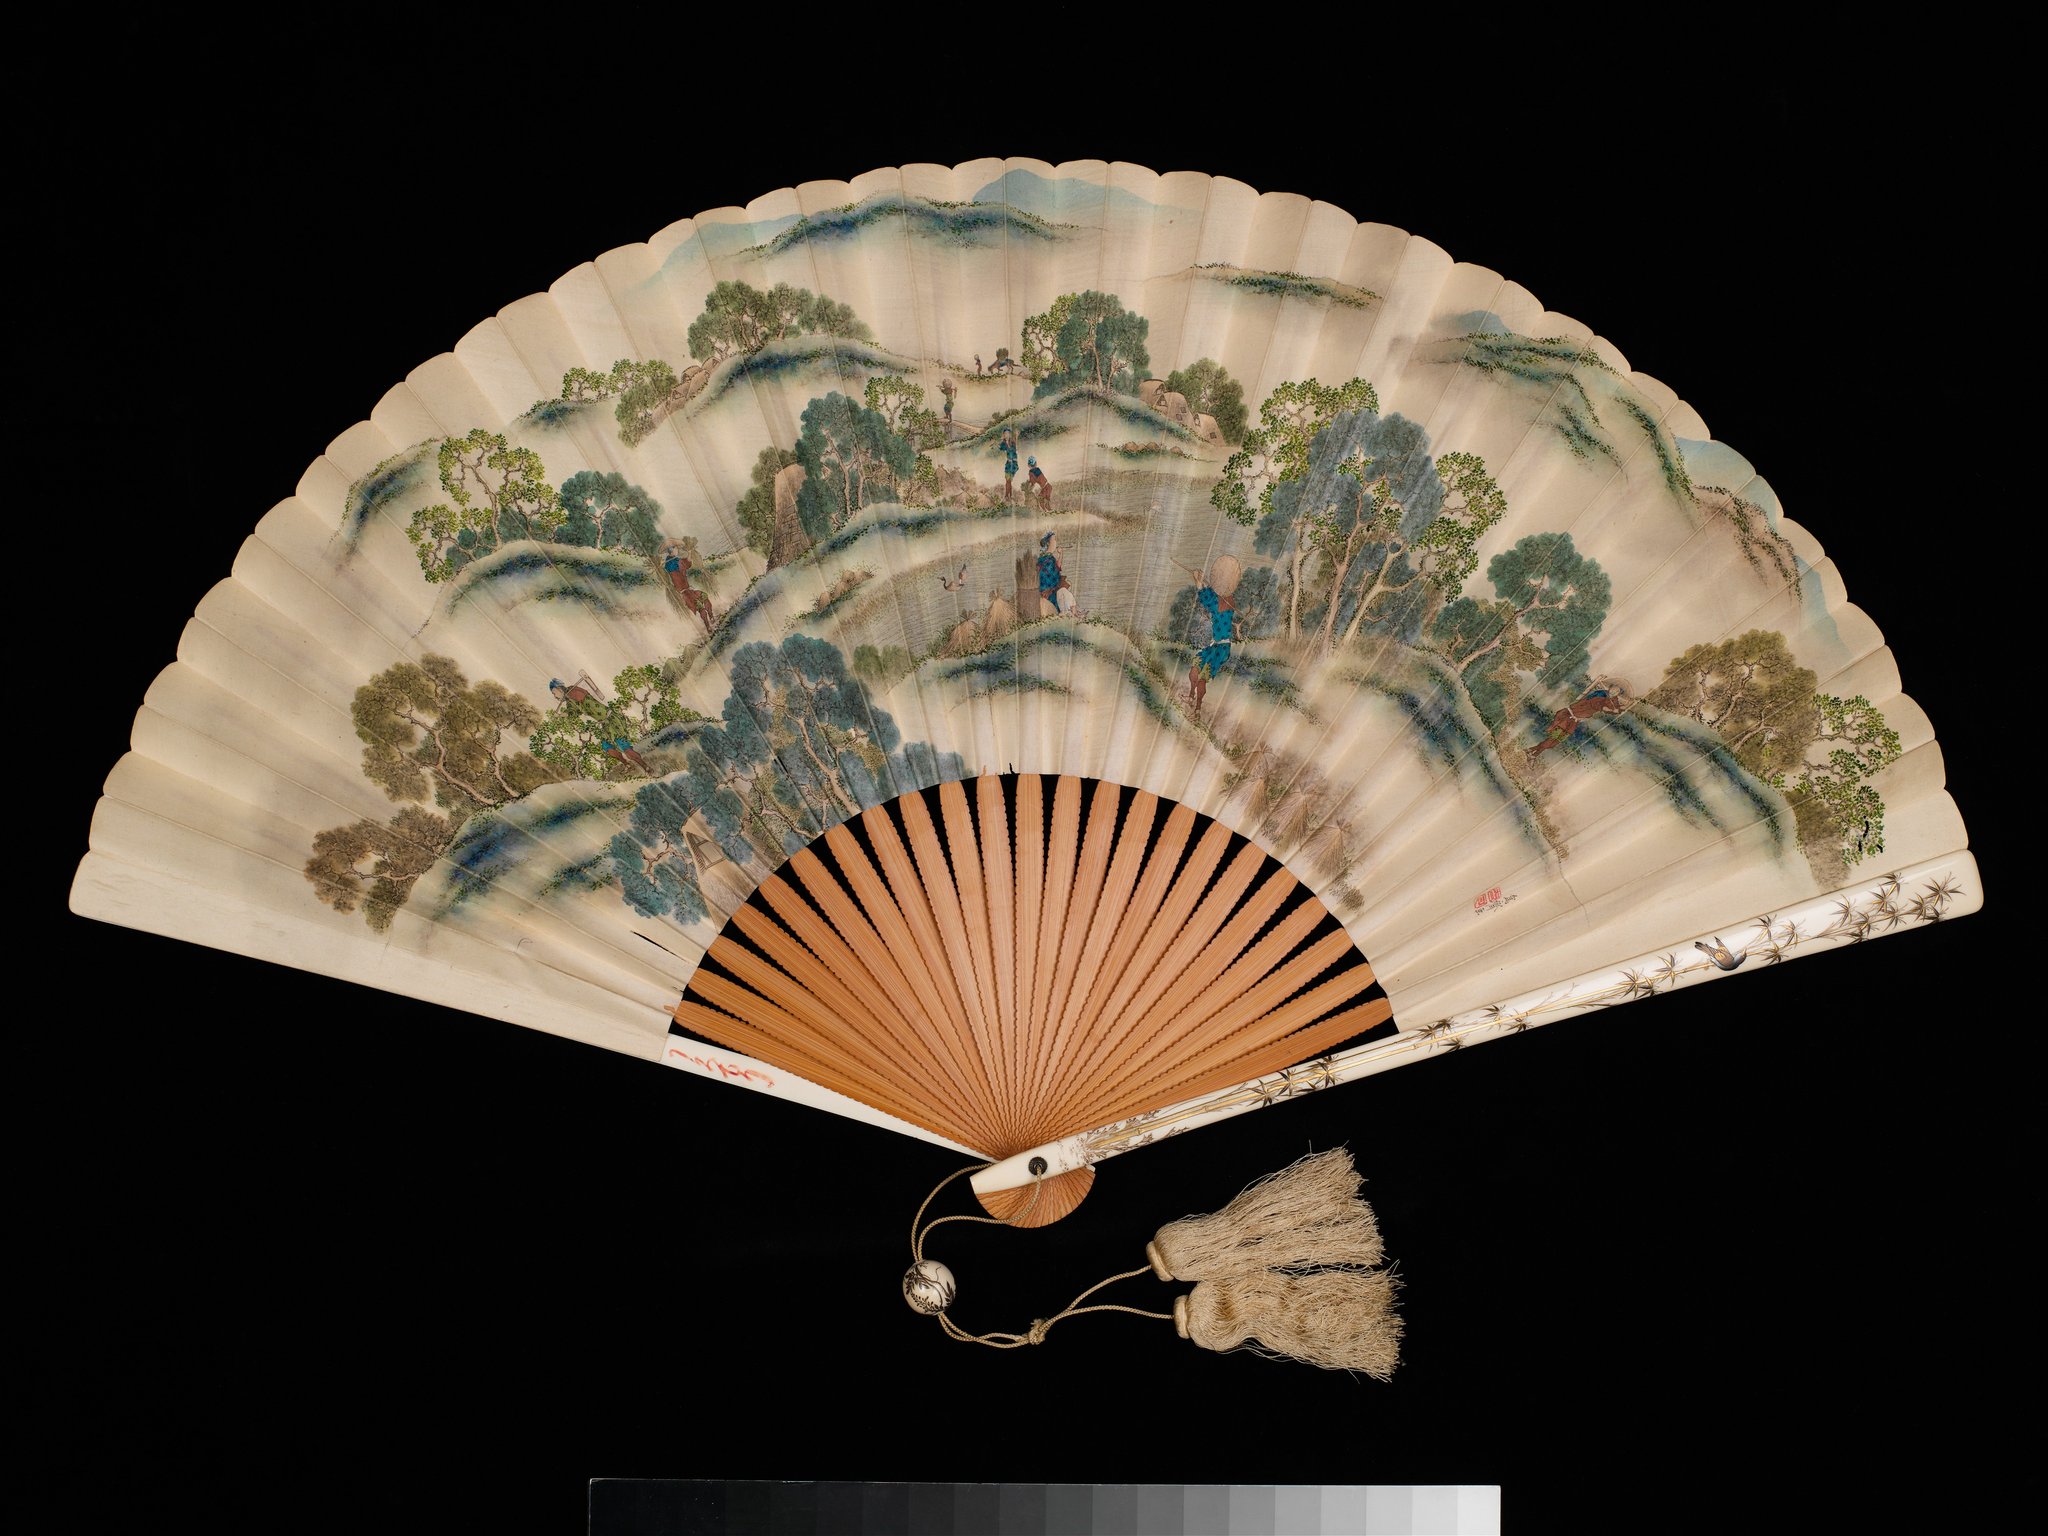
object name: folding fan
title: Winter Farming Scene; (verso) Autumn Farming Scene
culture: japanese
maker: katsushika isai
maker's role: artist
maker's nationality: japanese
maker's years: 1821-1880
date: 1821-1868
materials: ink, ivory, paper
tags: men,landscapes